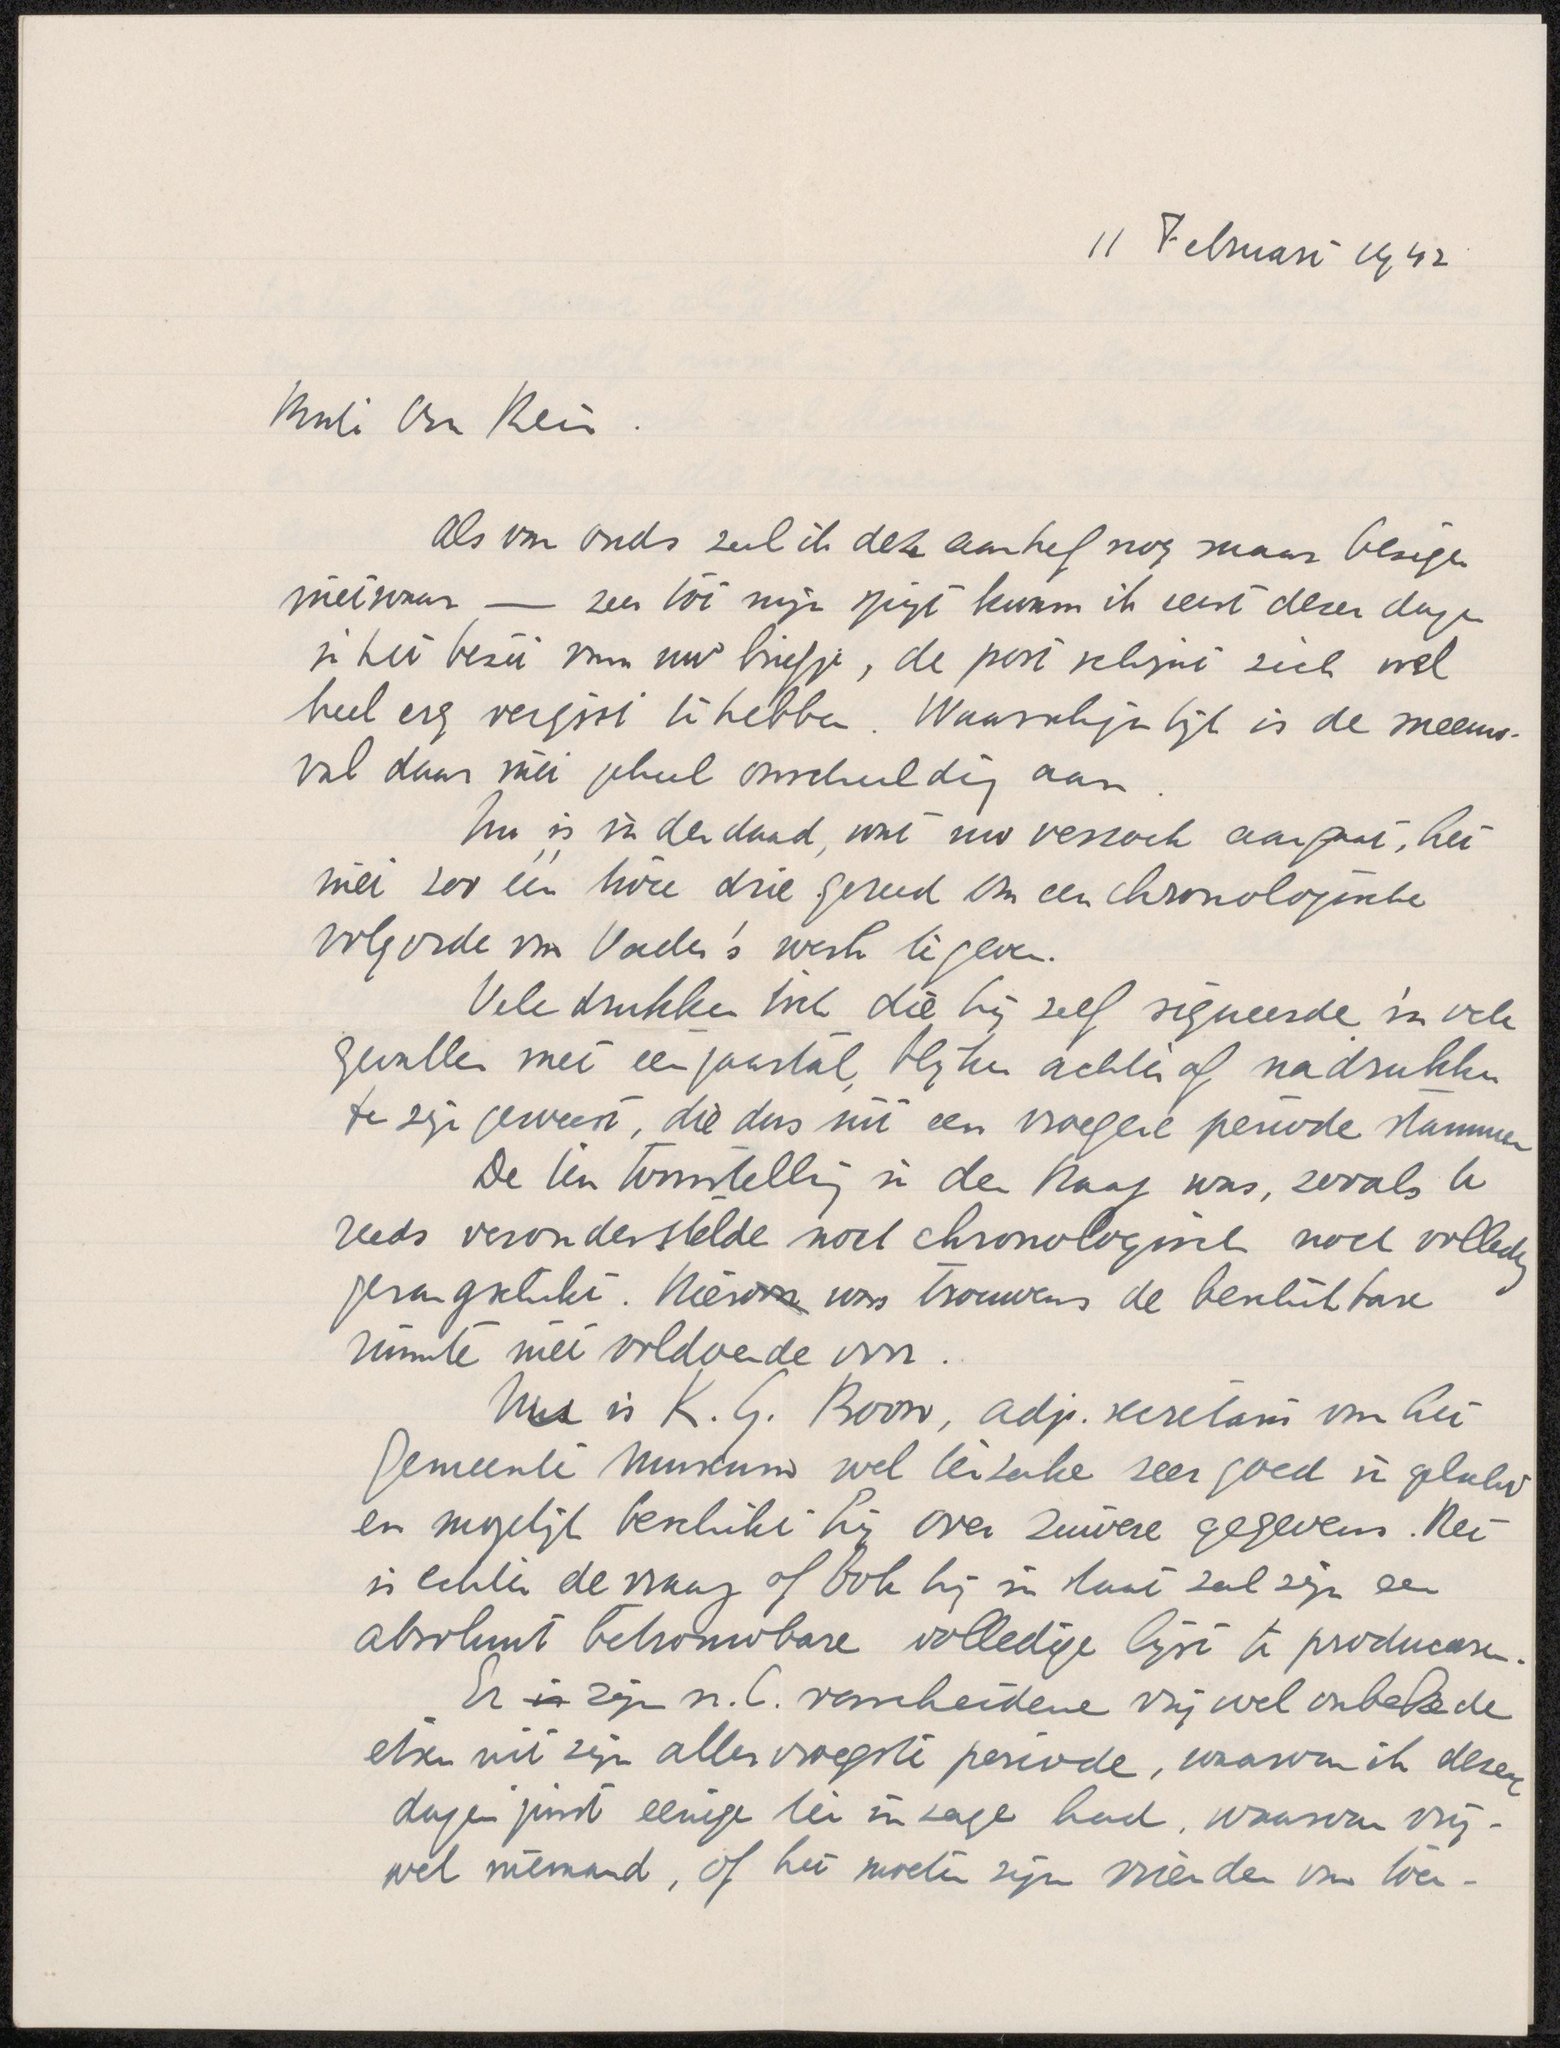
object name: letter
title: Brief aan Reinier Willem Petrus de Vries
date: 1942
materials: ink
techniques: pen, writing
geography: the hague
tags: print maker, draughtsman, willem vaarzon morel, maurits van der valk, amsterdam, painter, martin monnickendam, middelburg, george marinus tamson, reinier willem petrus de vries (1874-1953), haarlem, karel gerard boon, pieter dupont, the graphic arts, exhibition ~ art, historical persons (portraits and scenes from the life), the hague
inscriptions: collector's mark: ‘RPK’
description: Bij de brief wordt een aantekening van Klaas van Leeuwen uit 1913 betreffende Pieter Dupont bewaard.